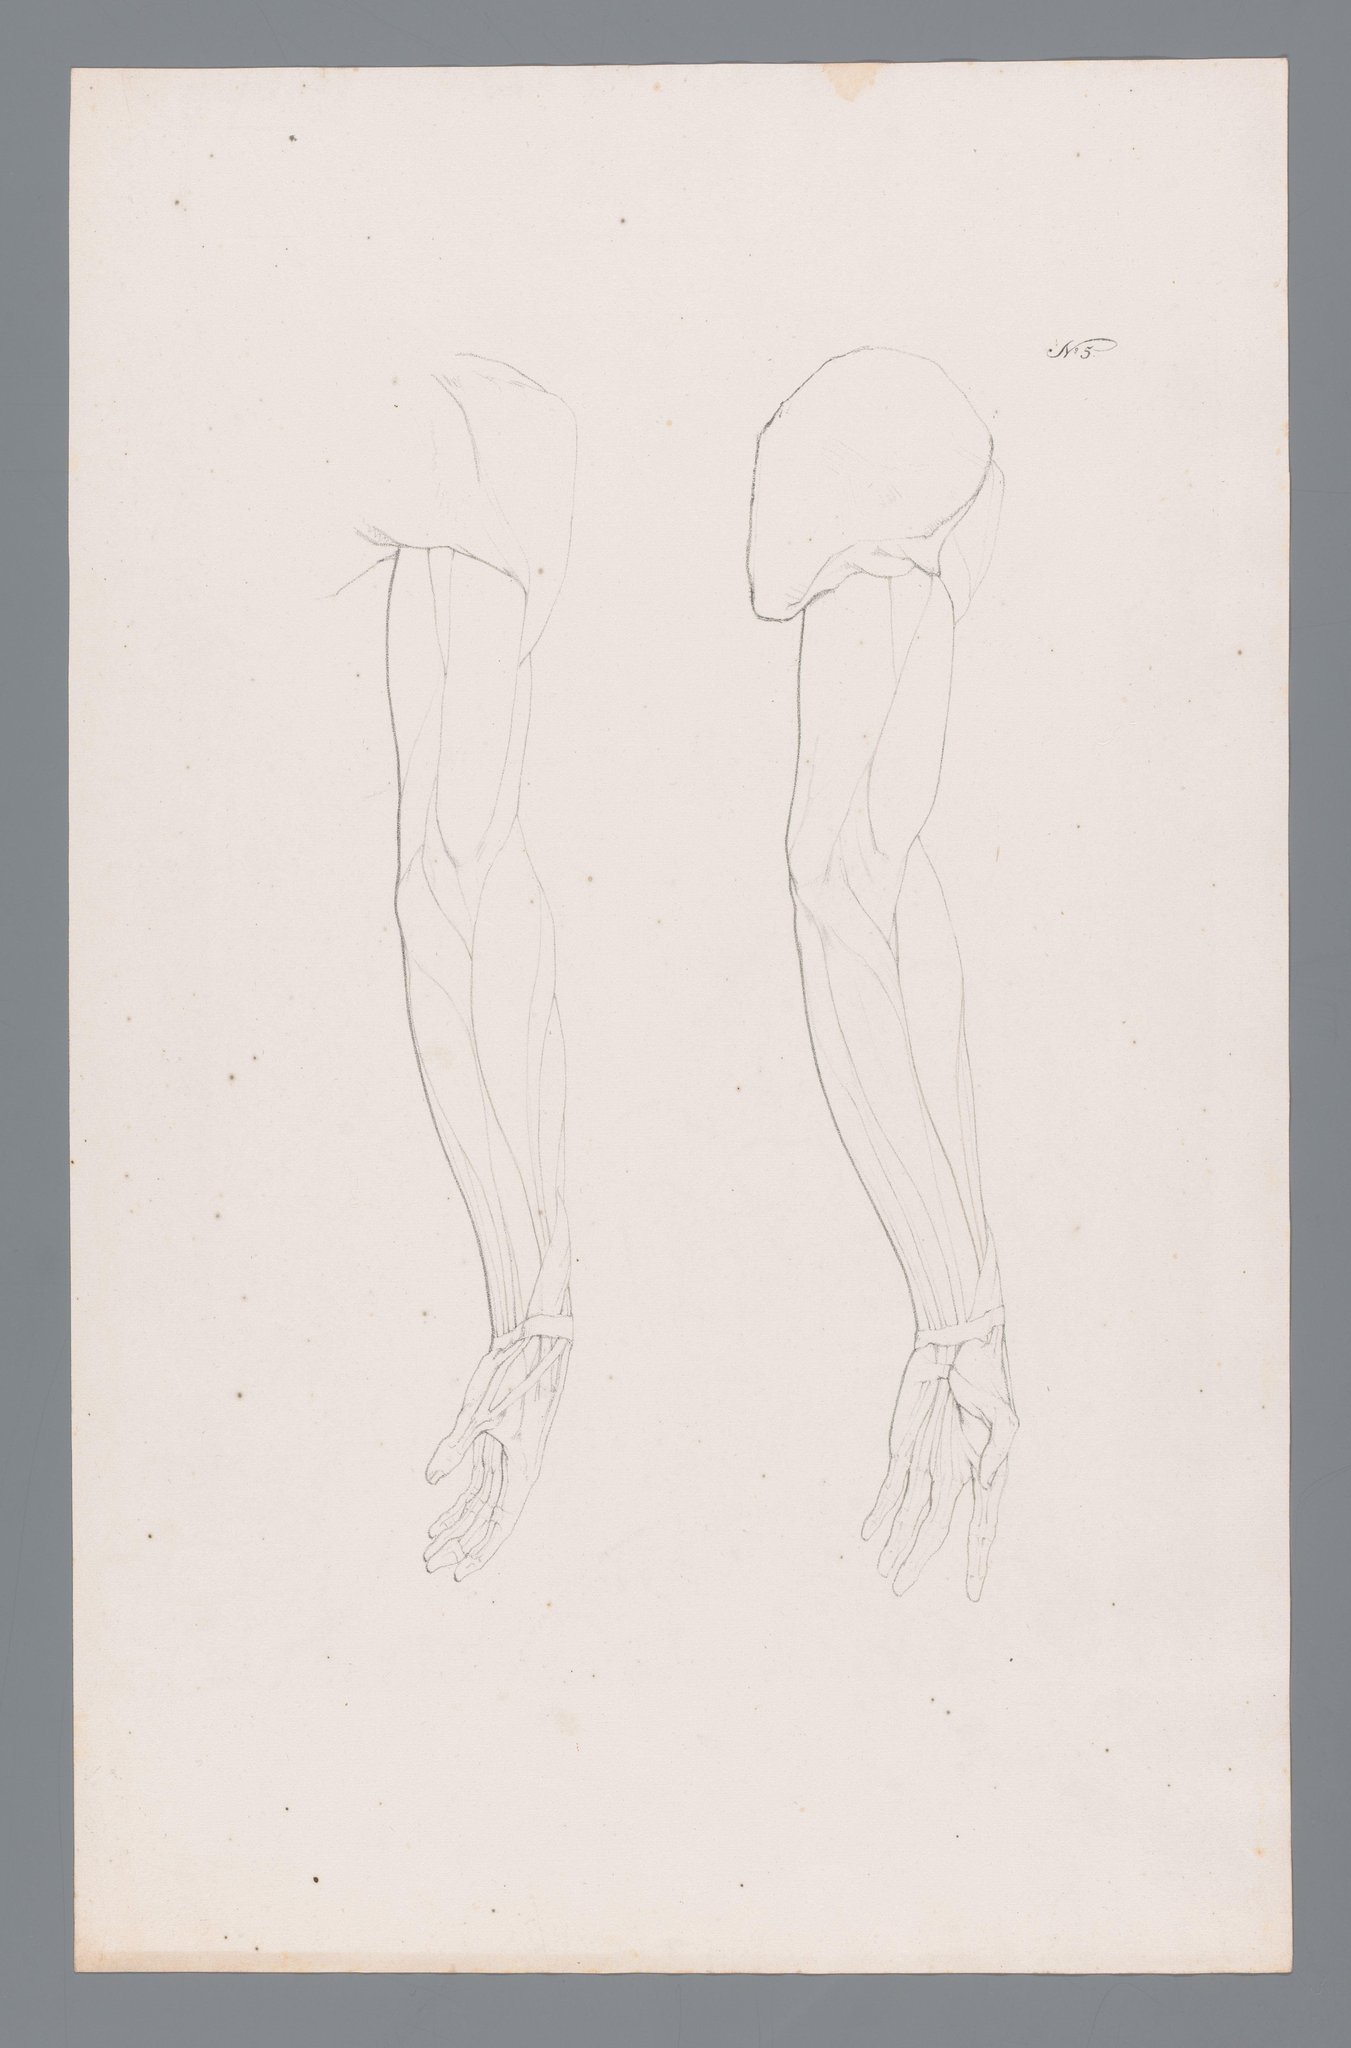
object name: print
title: Twee anatomieën van een arm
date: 1828-1830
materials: paper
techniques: lithograph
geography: amsterdam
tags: arms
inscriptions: collector's mark: Lugt 2228, watermark, collector's mark: Lugt 2760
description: Onderdeel van een omslag met een serie van twaalf anatomische voorstellingen.